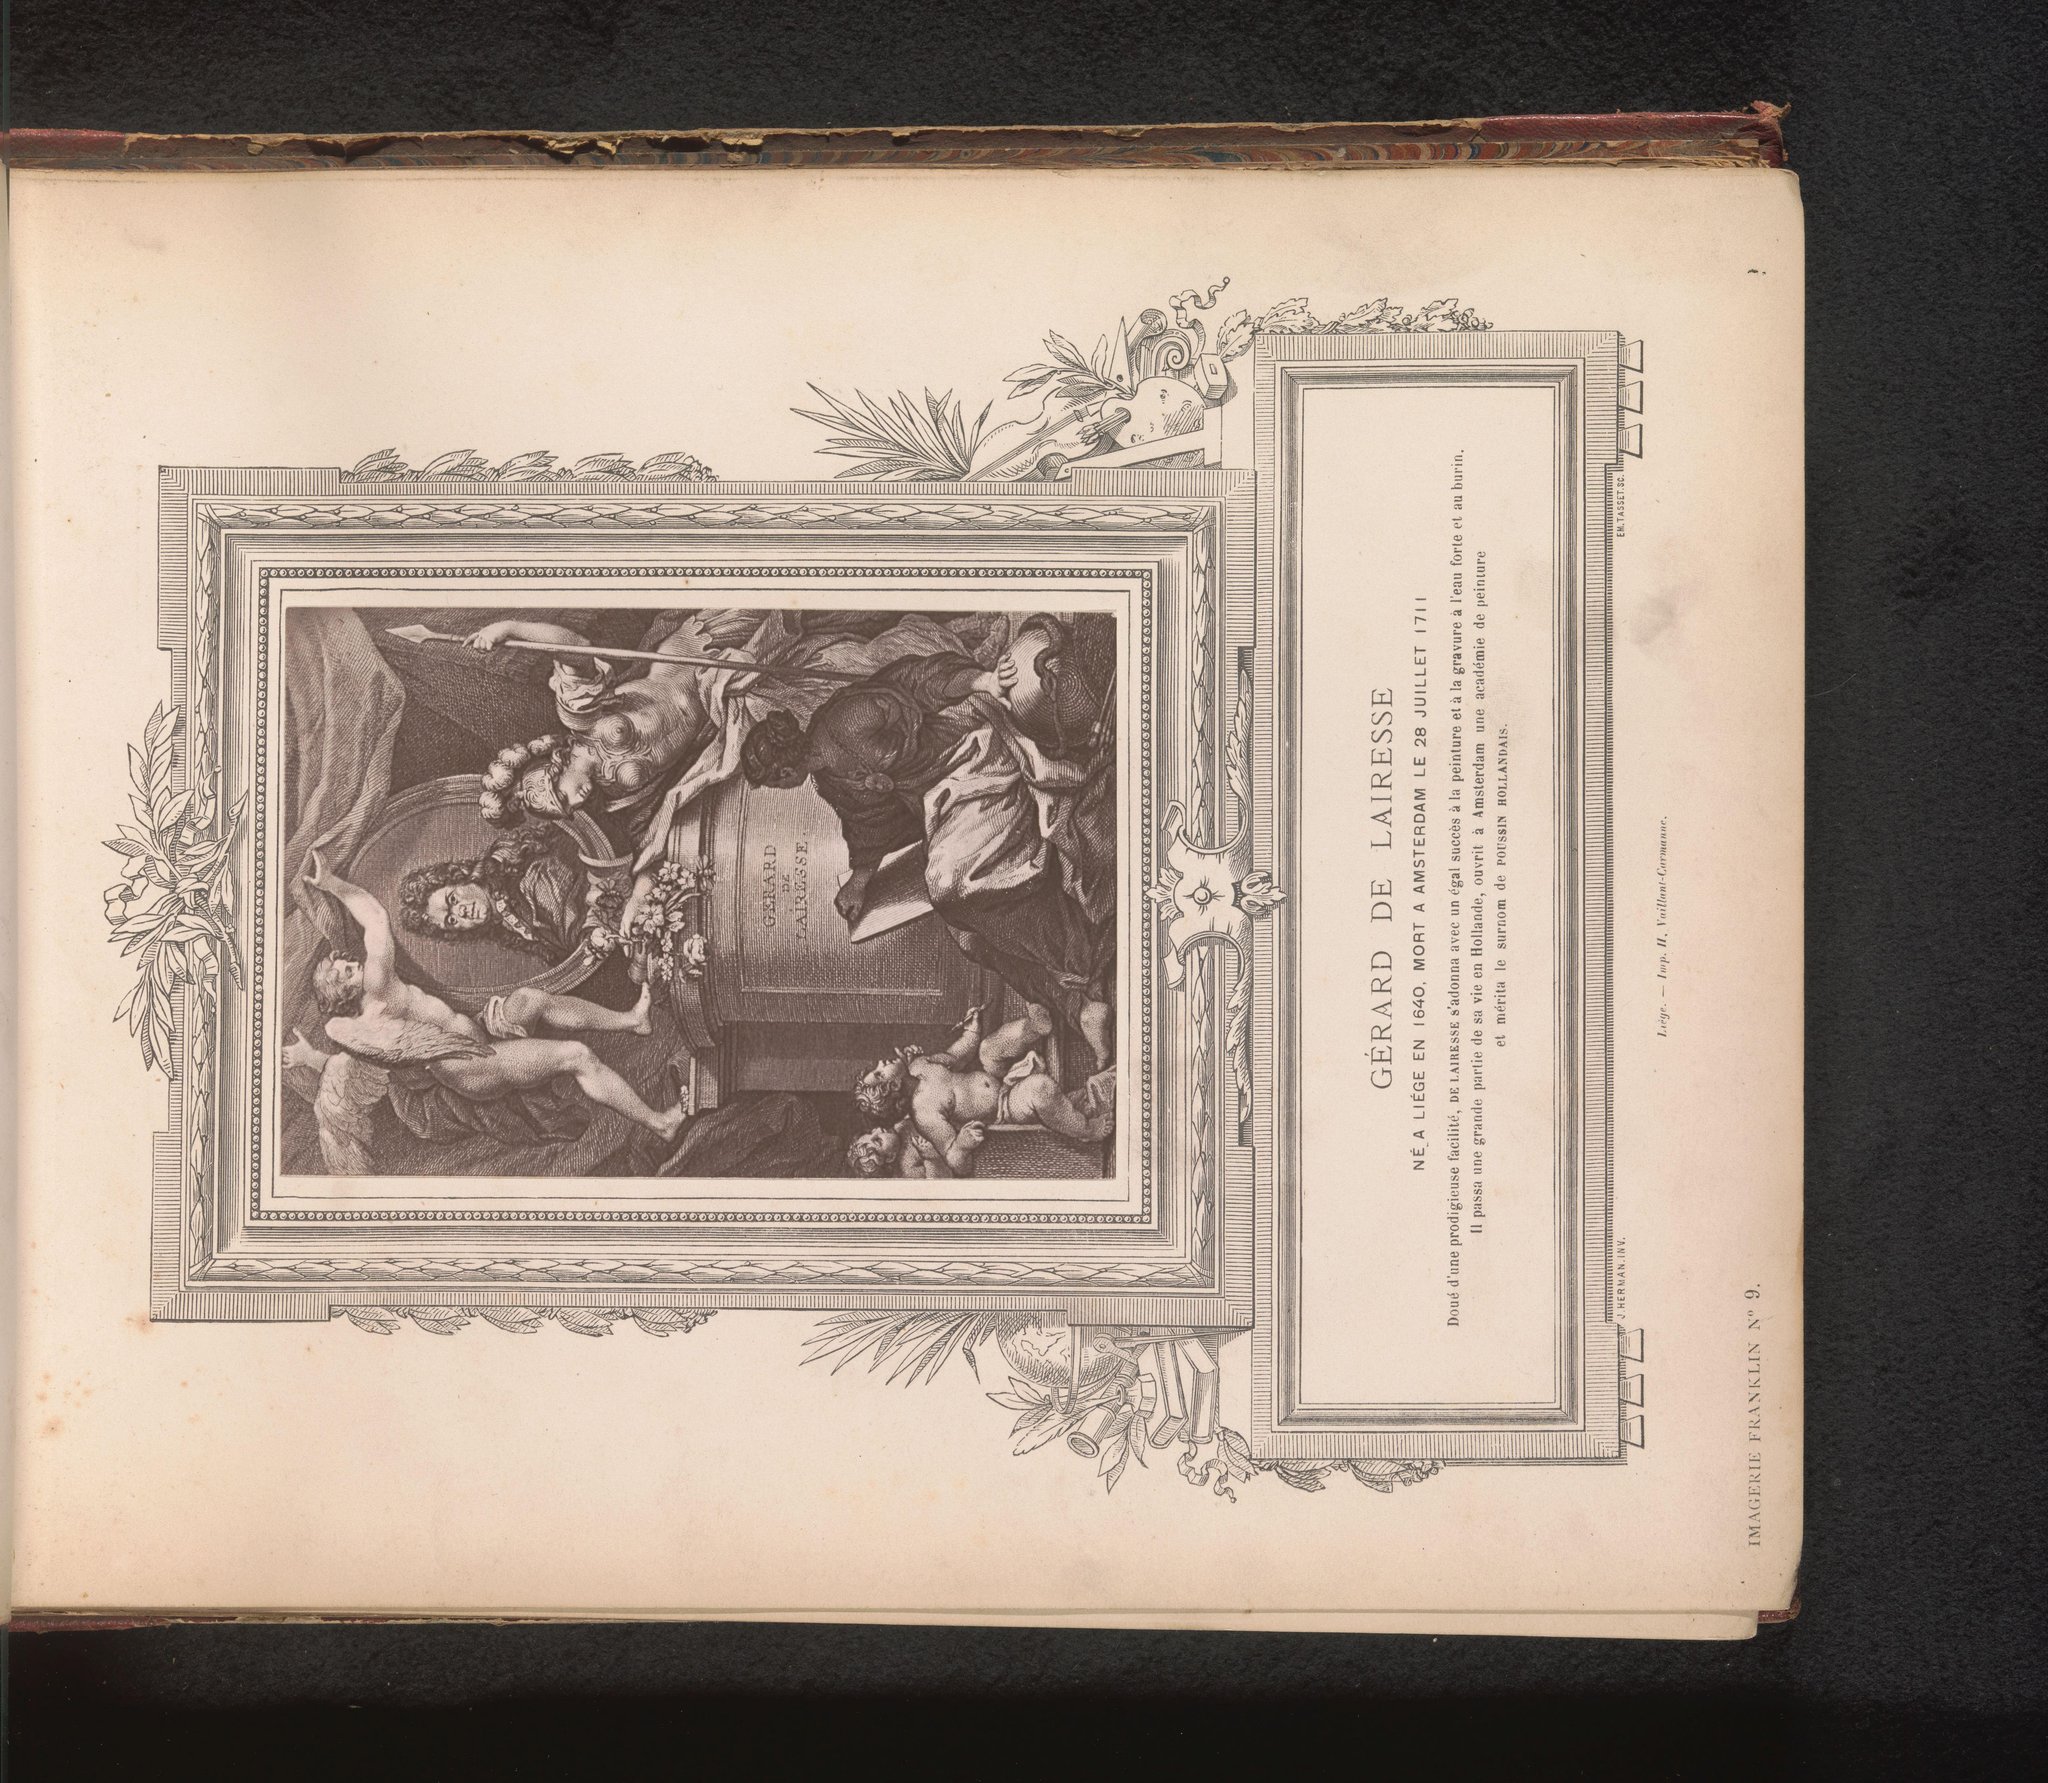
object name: reproduction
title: Reproductie van een prent van een gedecoreerd portret van Gérard de Lairesse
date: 1871-1880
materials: paper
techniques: woodburytype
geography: liège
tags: liège, painter, print maker, draughtsman, gerard de lairesse, historical persons, portrait, self-portrait of painter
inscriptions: name: ‘J. HERMAN, INV.’, inscription: ‘IMAGERIE FRANKLIN No 9.’, inscription: ‘NÉ A LIÈGE EN 1640, MORT A AMSTERDAM LE 28 JUILLIET 1711/ Doué d'une prodigieuse facilité, DE LAIRESSE s'adonna avec un égal succès à la peinture et à la gravure à l'eau forte et au burin./ Il passa une grande partie de sa vie en Hollande, ouvrit à Amsterdam une académie de peinture/ et mérita le surnom de POUSSIN HOLLANDAIS.’, name: ‘EM. TASSET, SC.’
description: Deze prent maakt deel uit van een album.